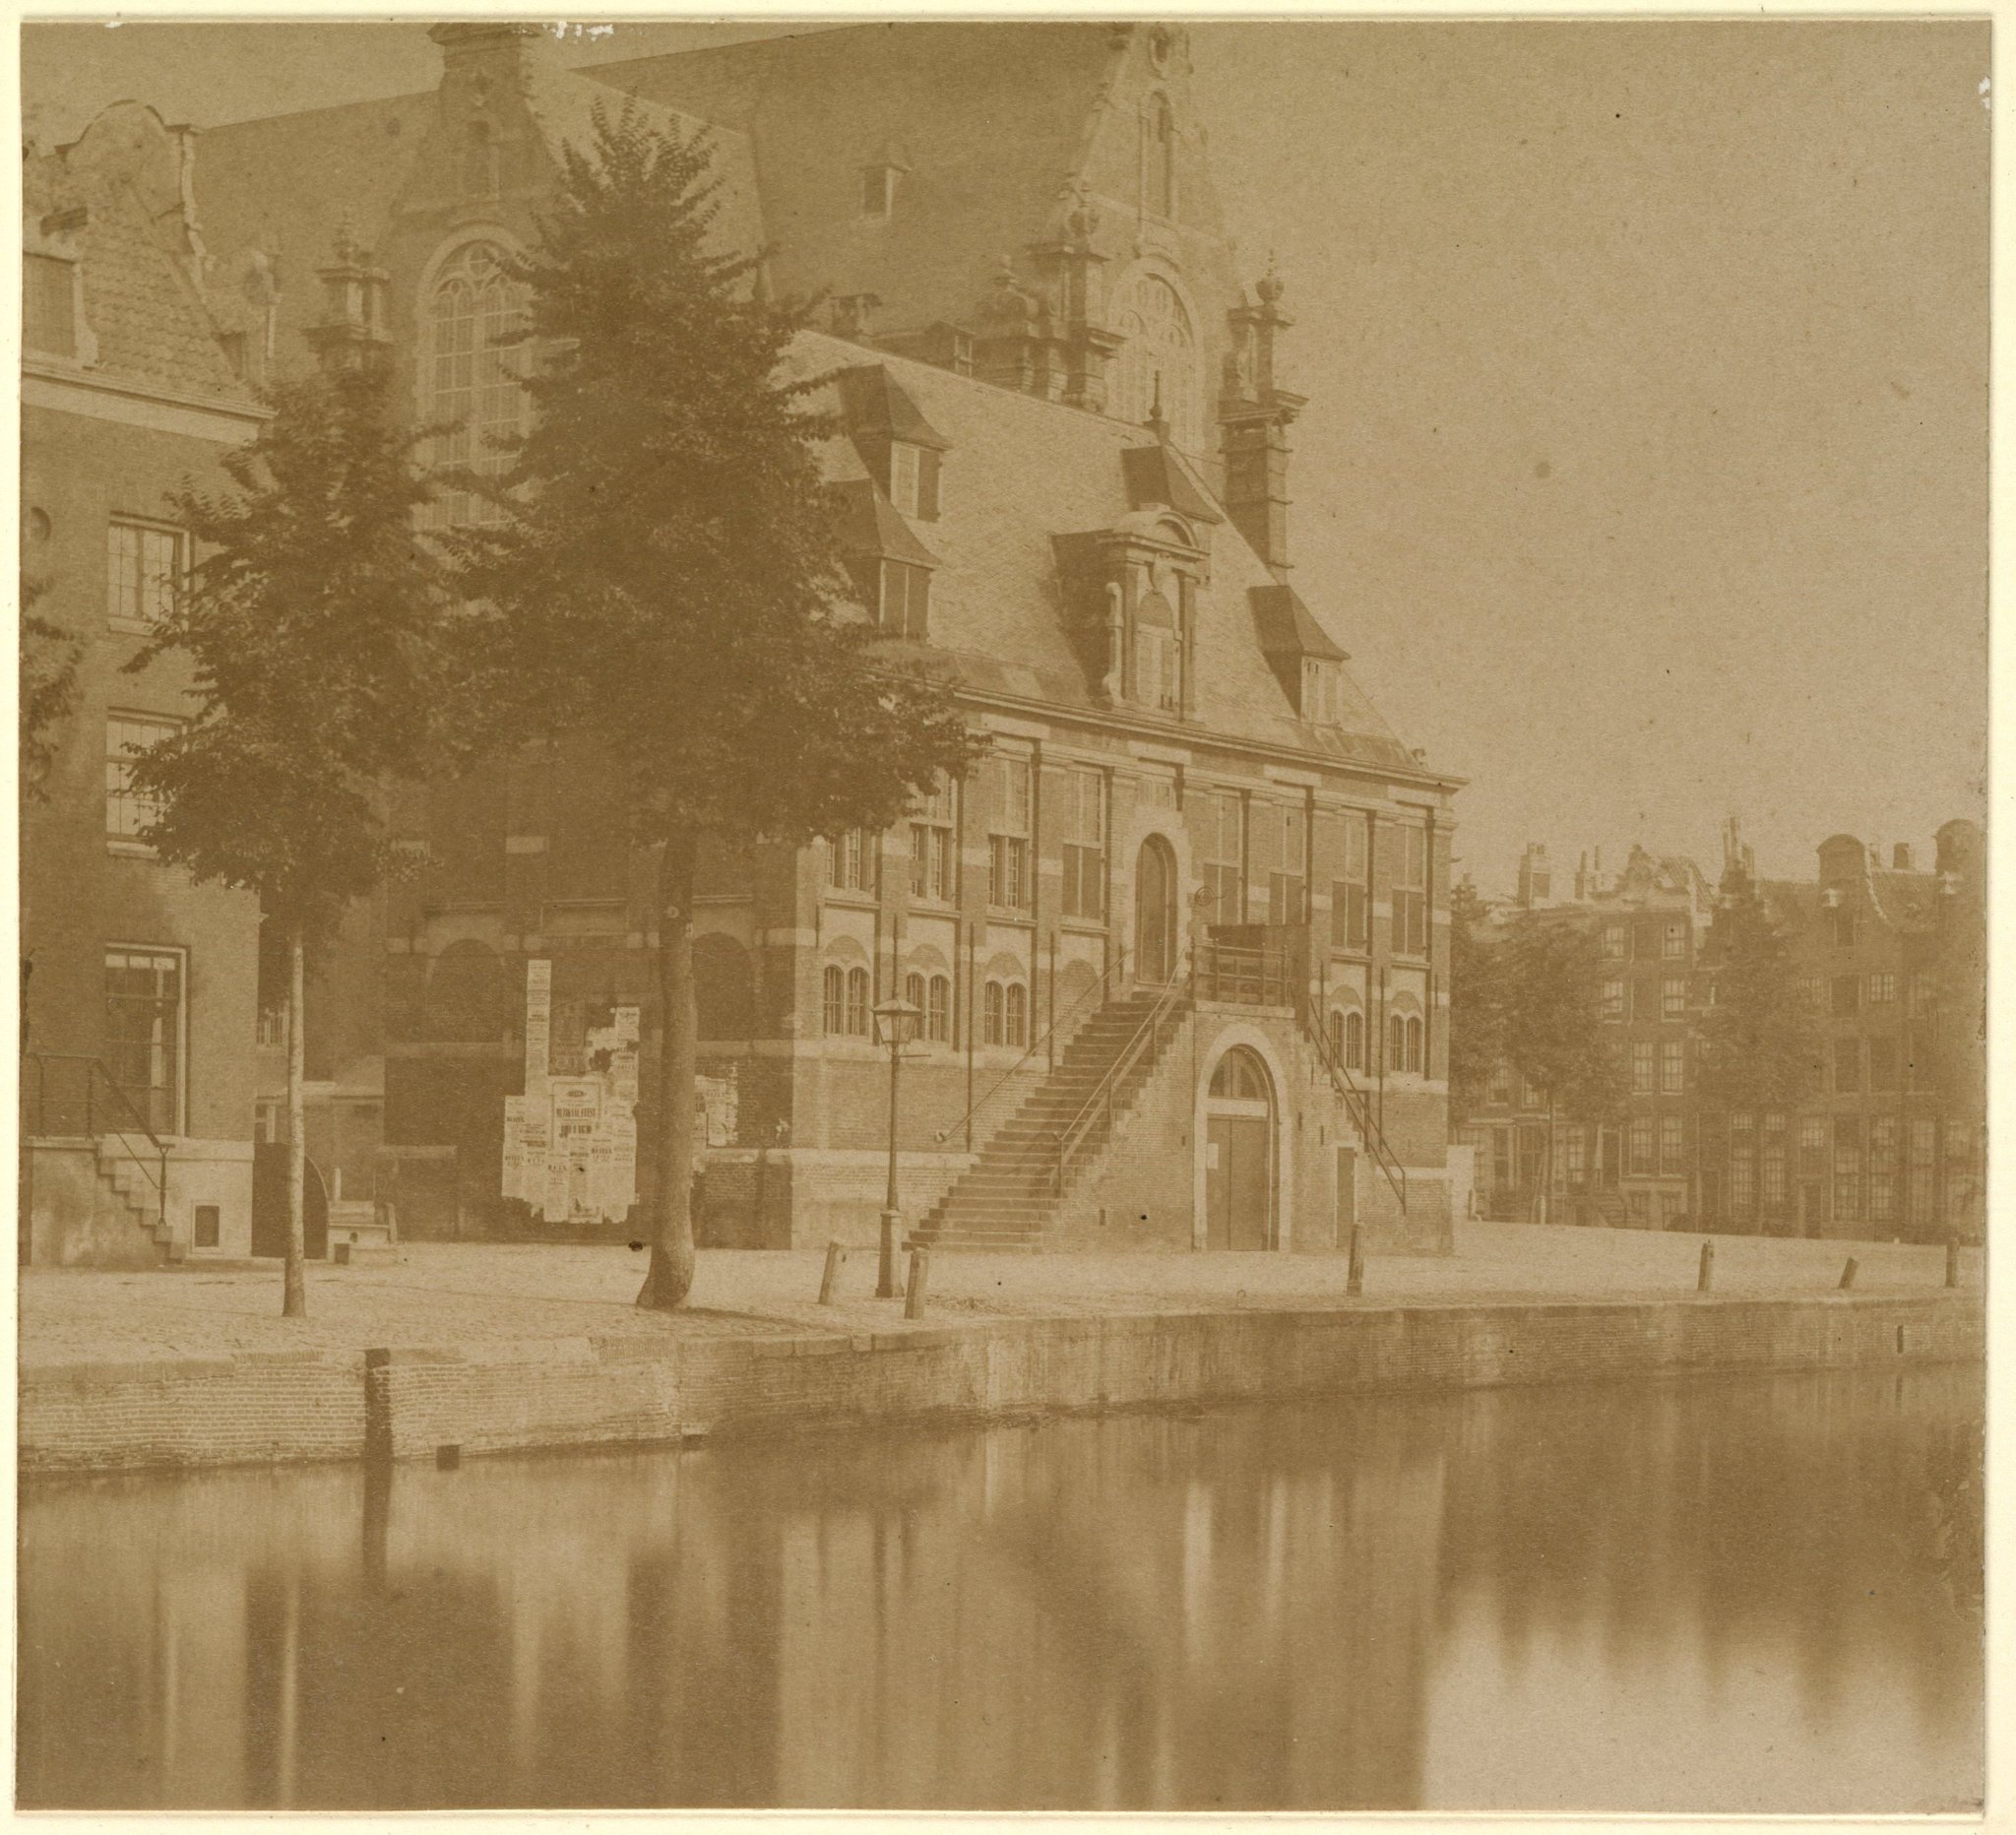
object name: photograph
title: De Waag op de Westermarkt te Amsterdam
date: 1857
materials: cardboard, paper, photographic support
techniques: albumen print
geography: amsterdam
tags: weigh-house